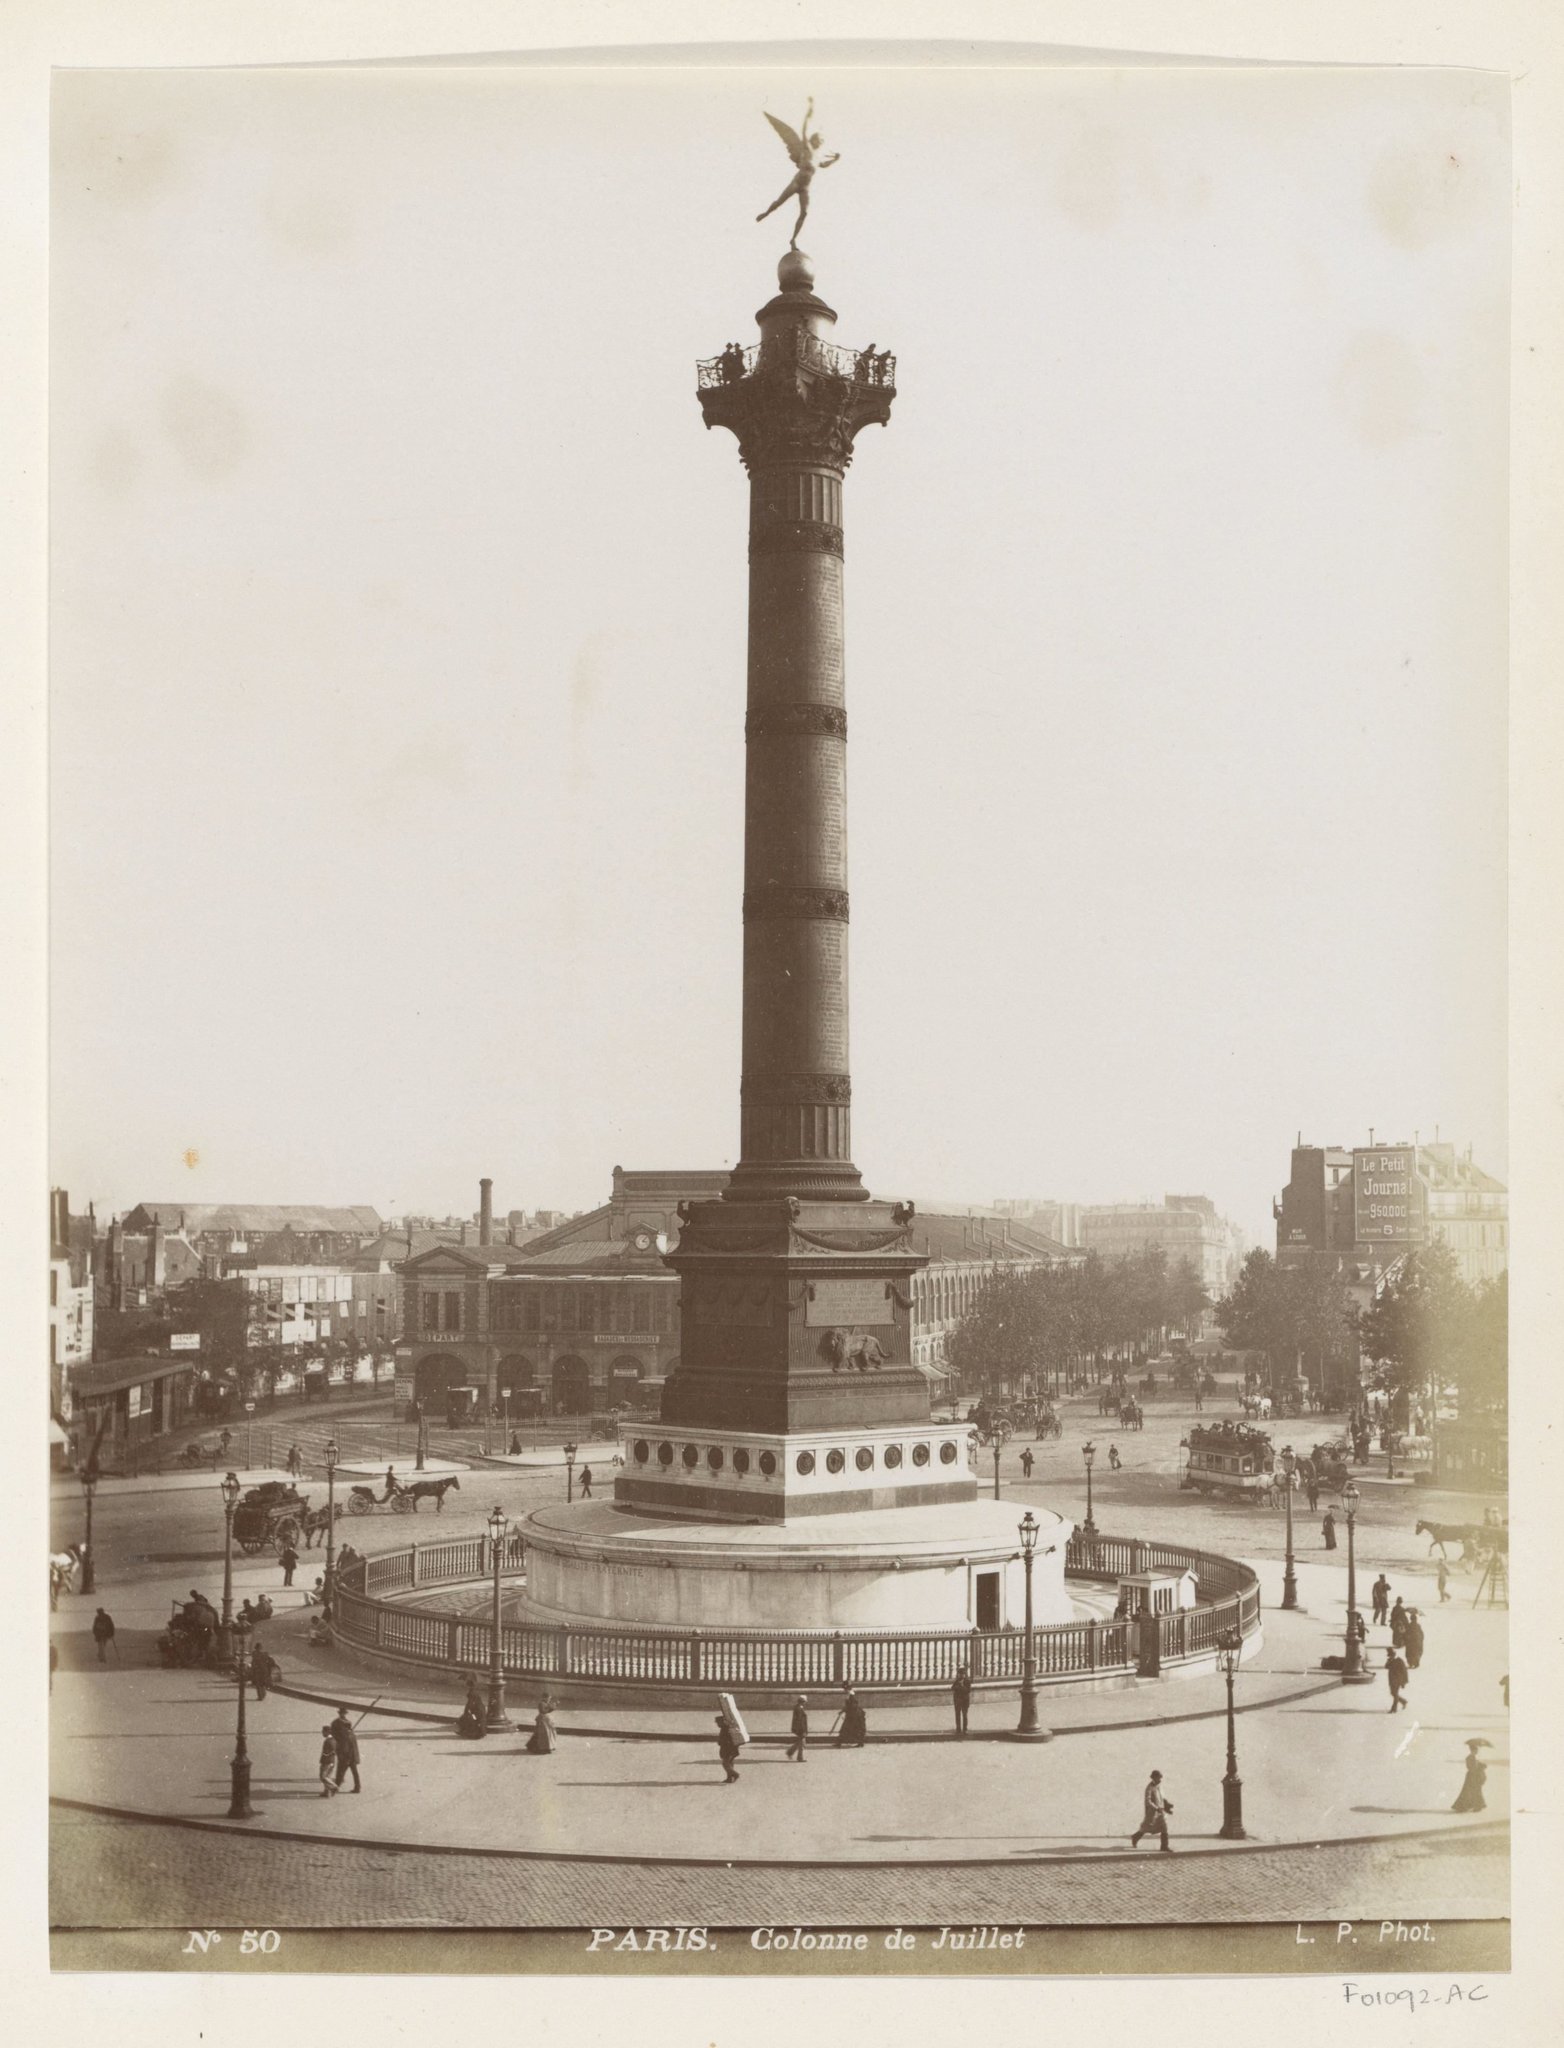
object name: photograph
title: Colonne de Juillet op de Place de la Bastille in Parijs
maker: louis antoine pamard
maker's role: fotograaf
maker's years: 1840-1893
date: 1880-1900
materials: cardboard, paper, photographic support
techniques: albumen print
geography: paris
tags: monument, statue (+ city(-scape) with figures, staffage), square, place, circus, etc. (+ city(-scape) with figures, staffage), paris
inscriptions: negative number: ‘50’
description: Onderdeel van Reisalbum met foto's van bezienswaardigheden in België en Frankrijk.